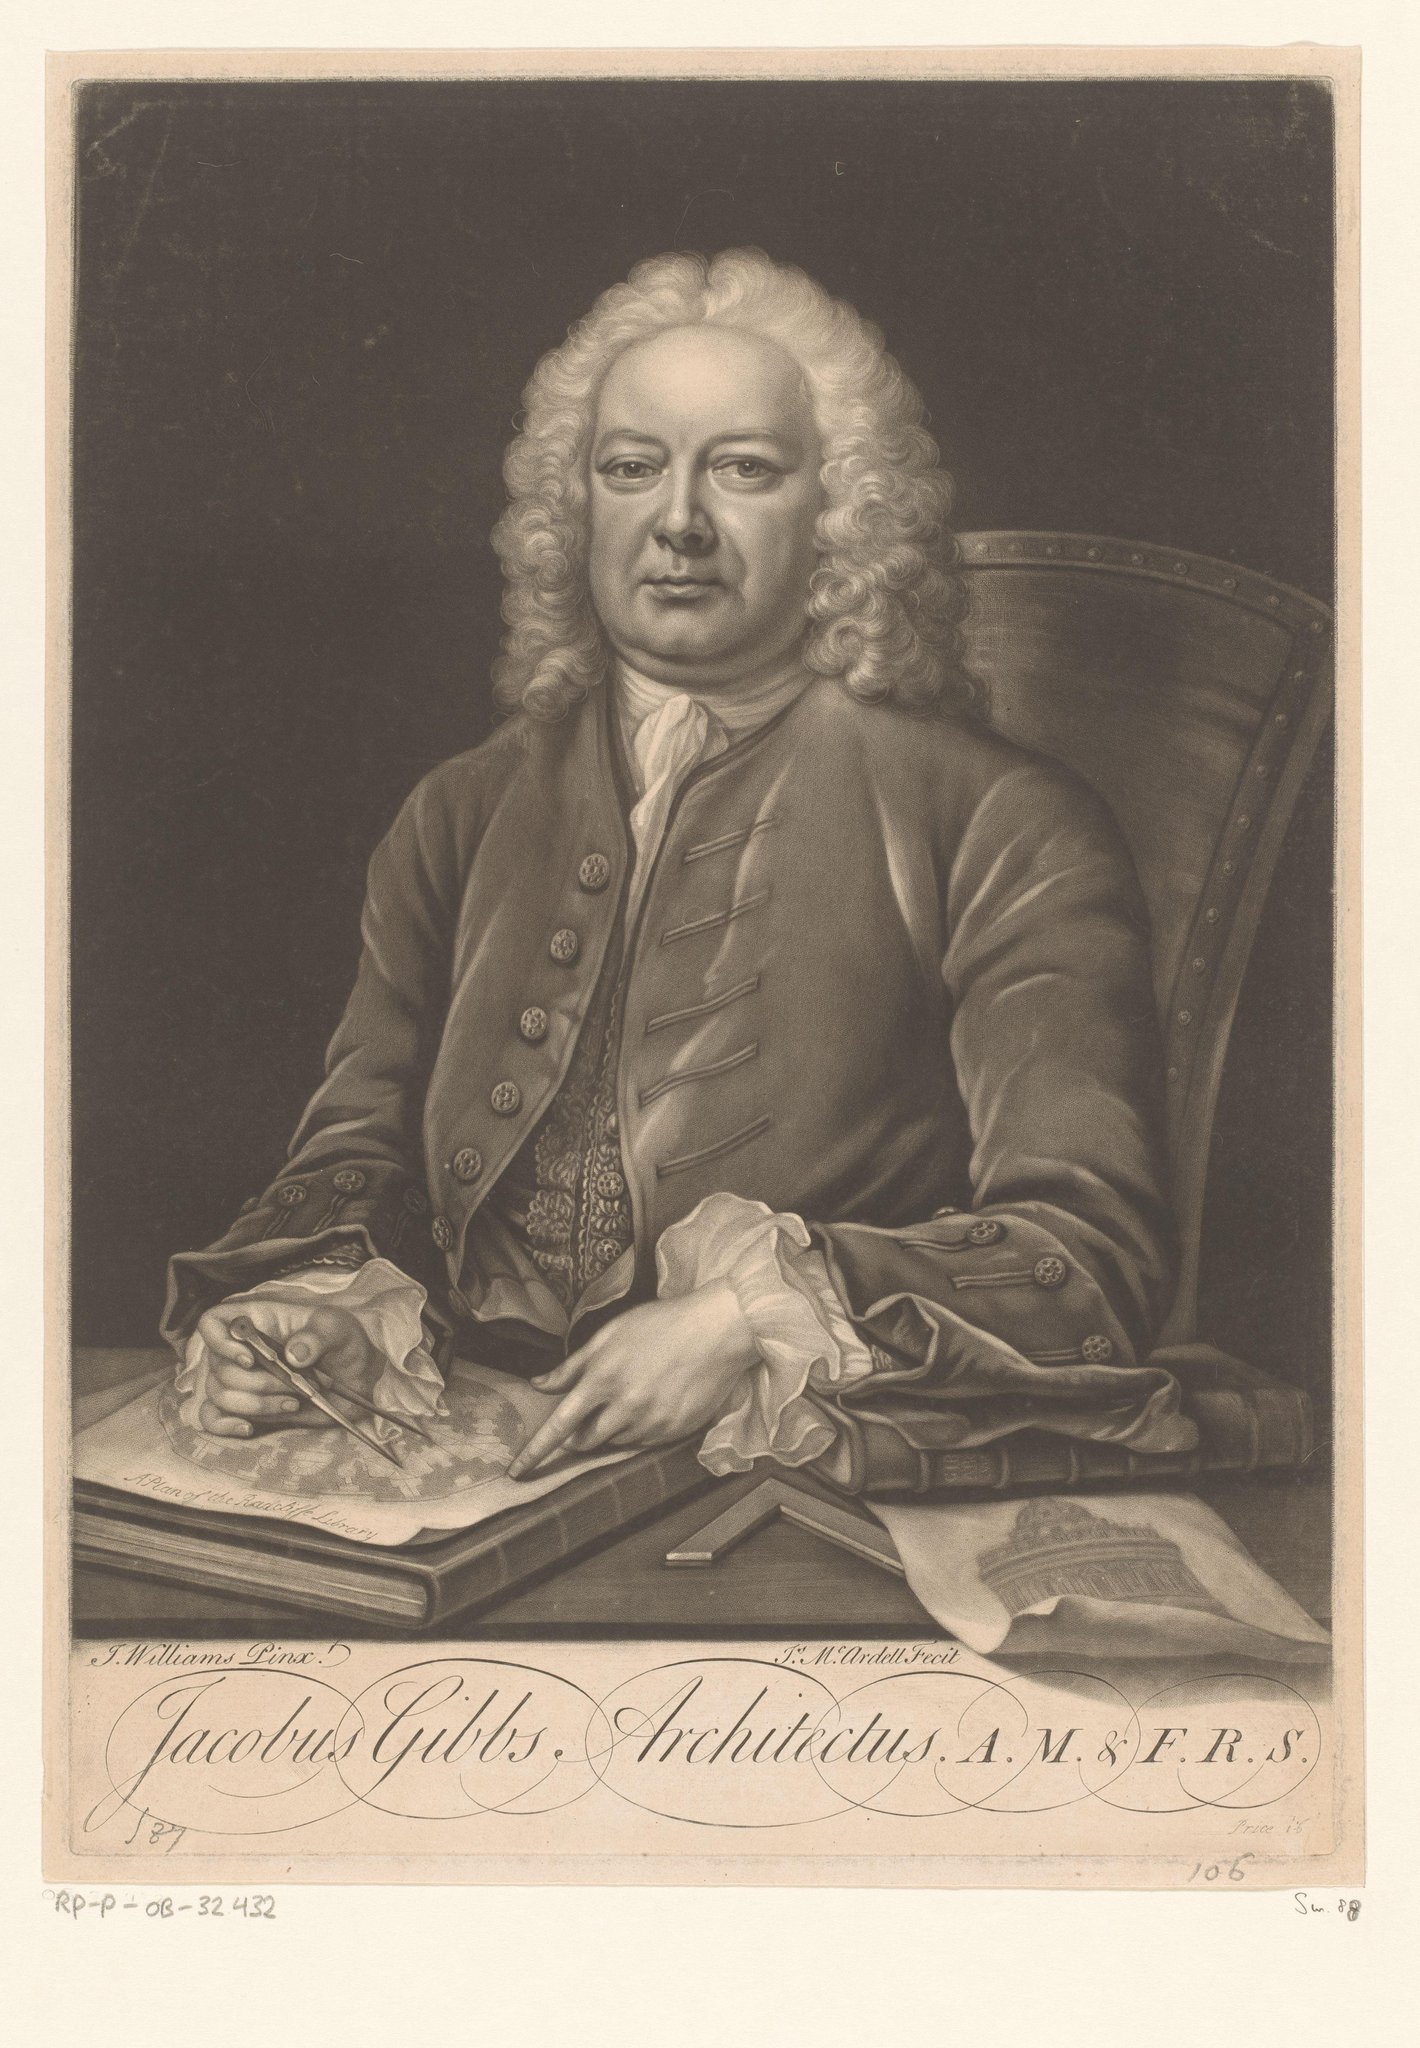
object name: print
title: Portret van James Gibbs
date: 1740-1754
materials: paper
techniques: mezzotint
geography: london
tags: james gibbs, historical persons, portrait, self-portrait of architect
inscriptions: collector's mark: Lugt 240